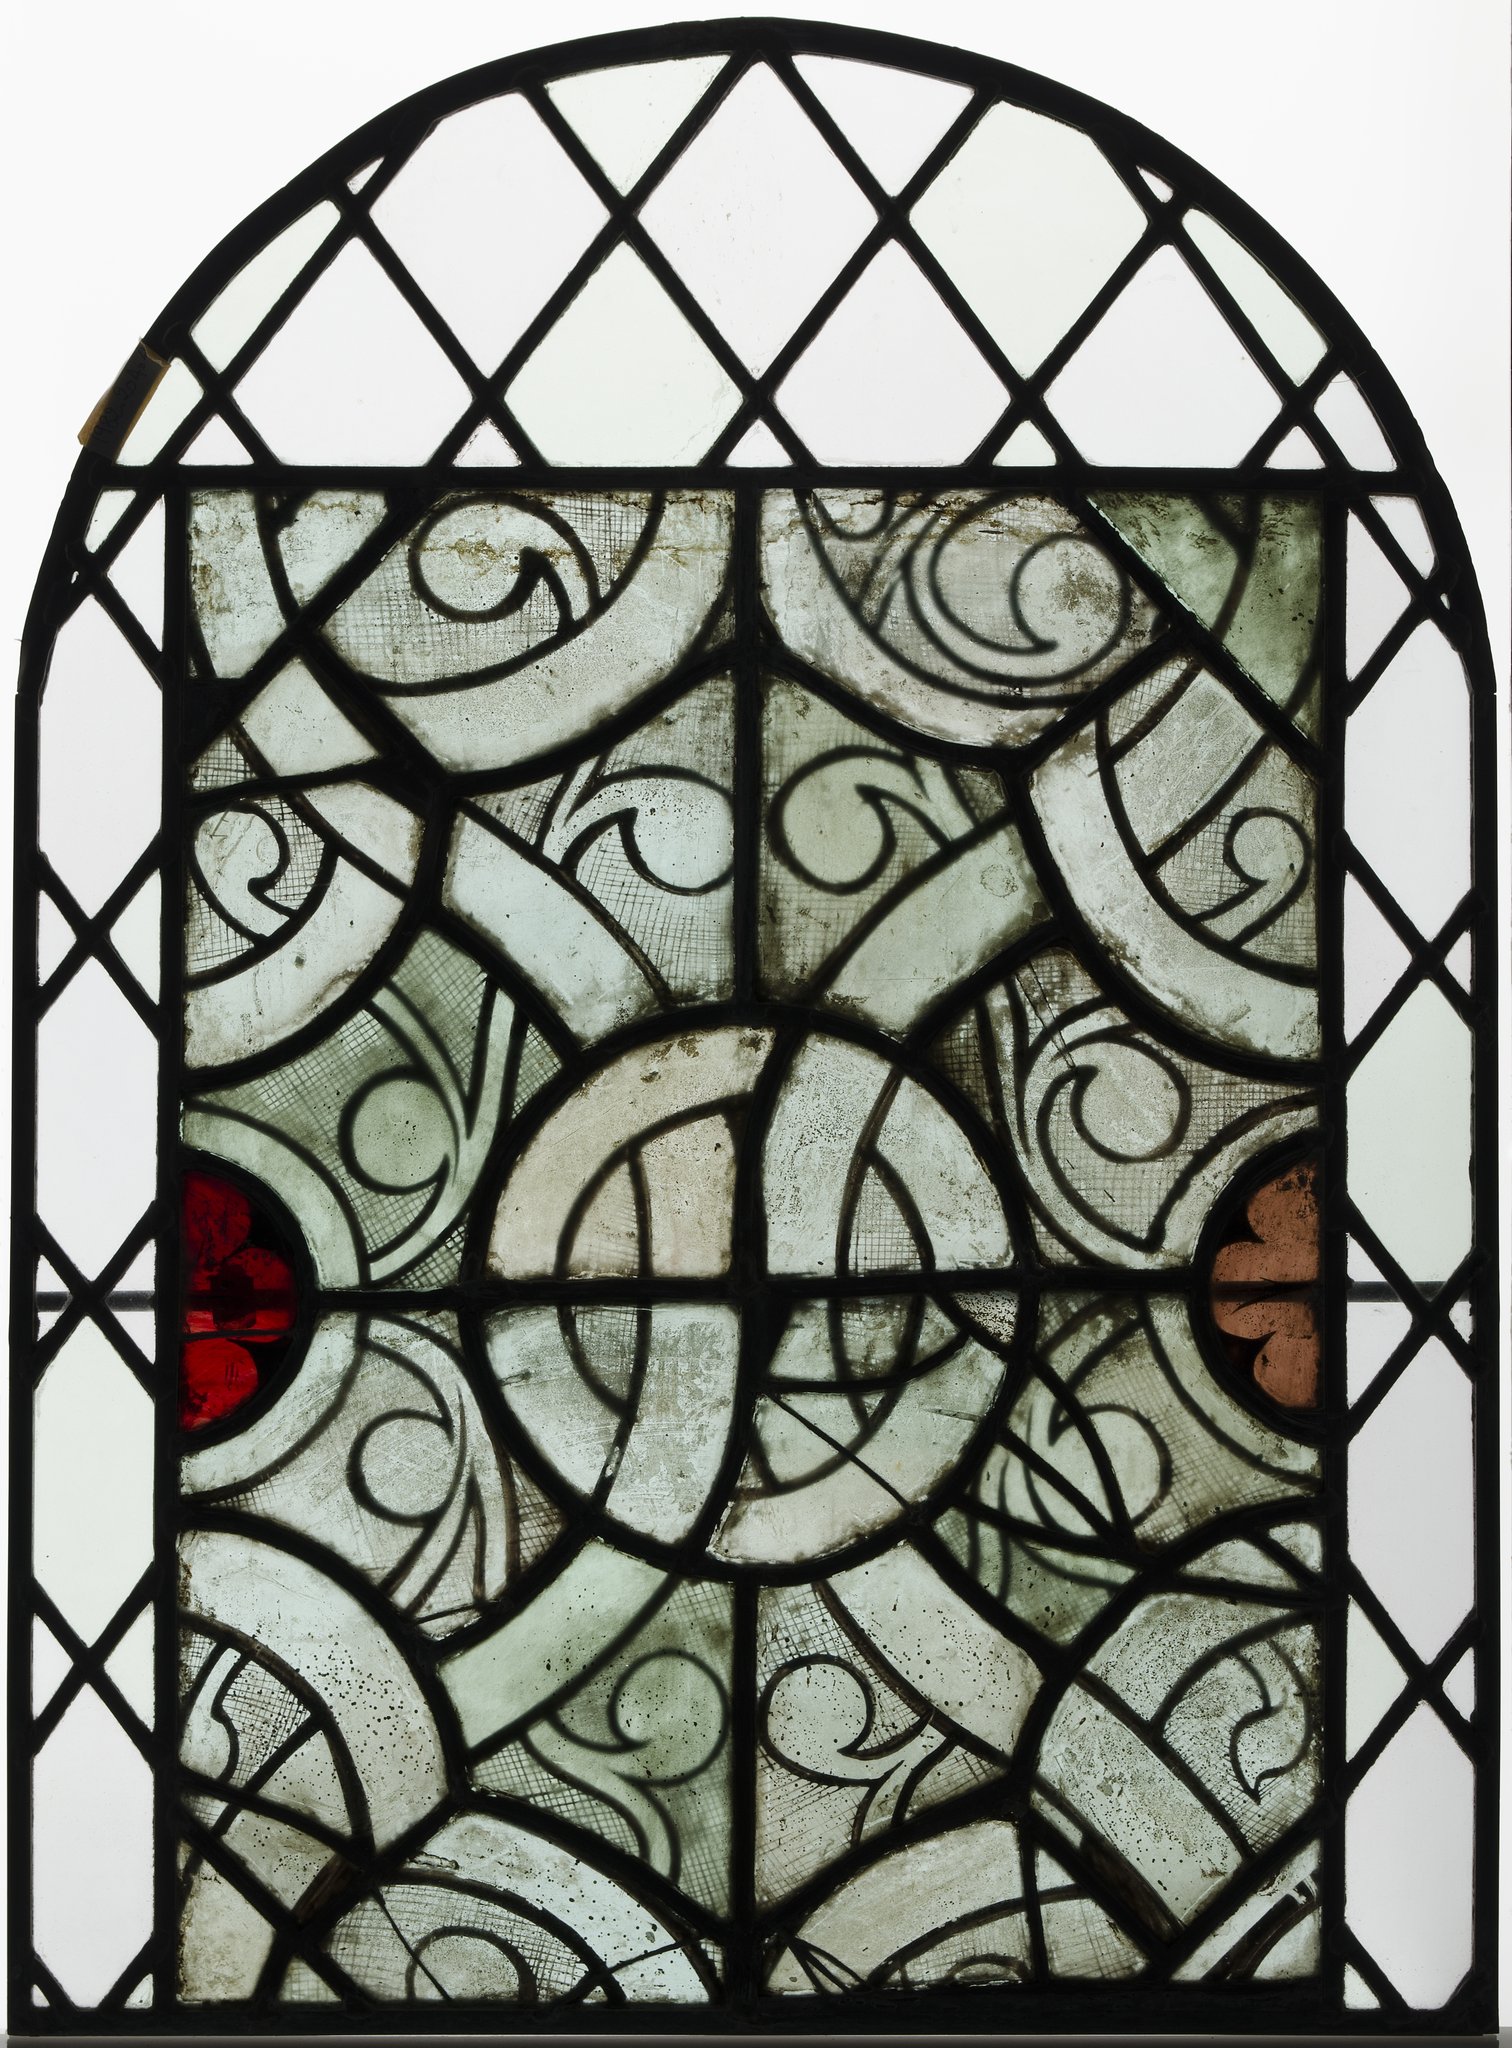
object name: panel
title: Glass panel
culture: french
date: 1250-1270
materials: glass, metal, paint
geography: france